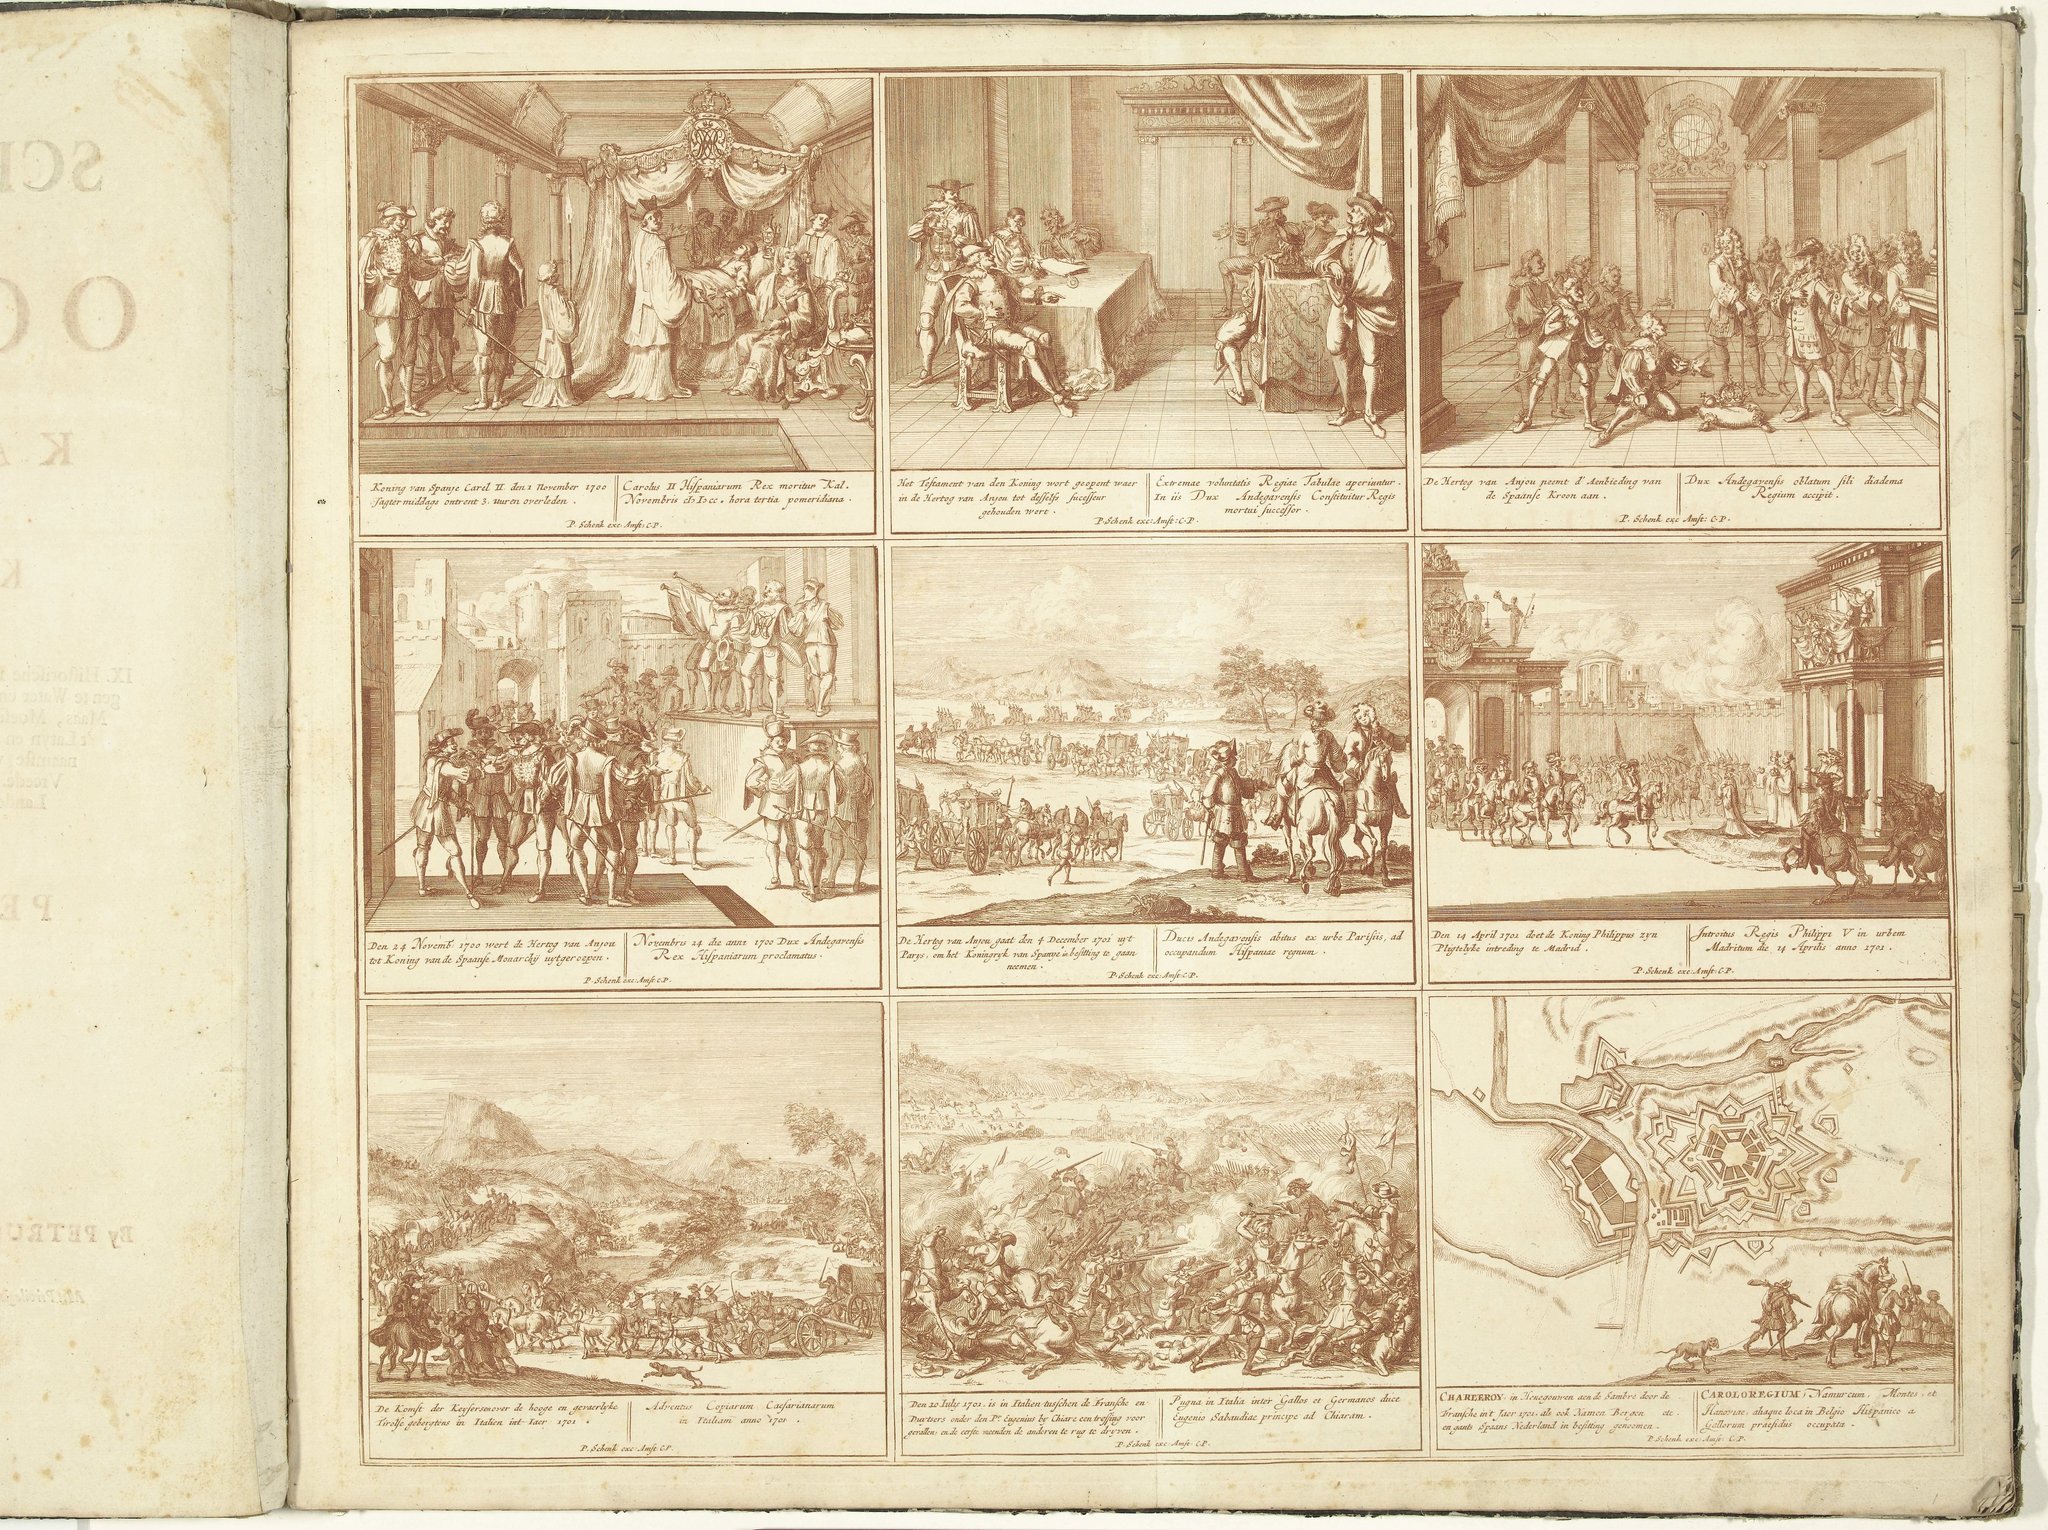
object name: print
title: Schouwburg van den oorlog (blad I), 1700-1701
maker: pieter schenk (i)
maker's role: print maker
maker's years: 1660-1711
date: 1701-1706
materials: paper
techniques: etching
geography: amsterdam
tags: karel ii (koning van spanje), filips v (koning van spanje), battle (+ land forces)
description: Blad met negen voorstellingen van gebeurtenissen uit de jaren 1700-1701 van de Spaanse Successieoorlog, Blad I in: Schouwburg van den oorlog (editie van 1709), het prentwerk met de gebundelde reeks van 18 platen over de Spaanse Successieoorlog.